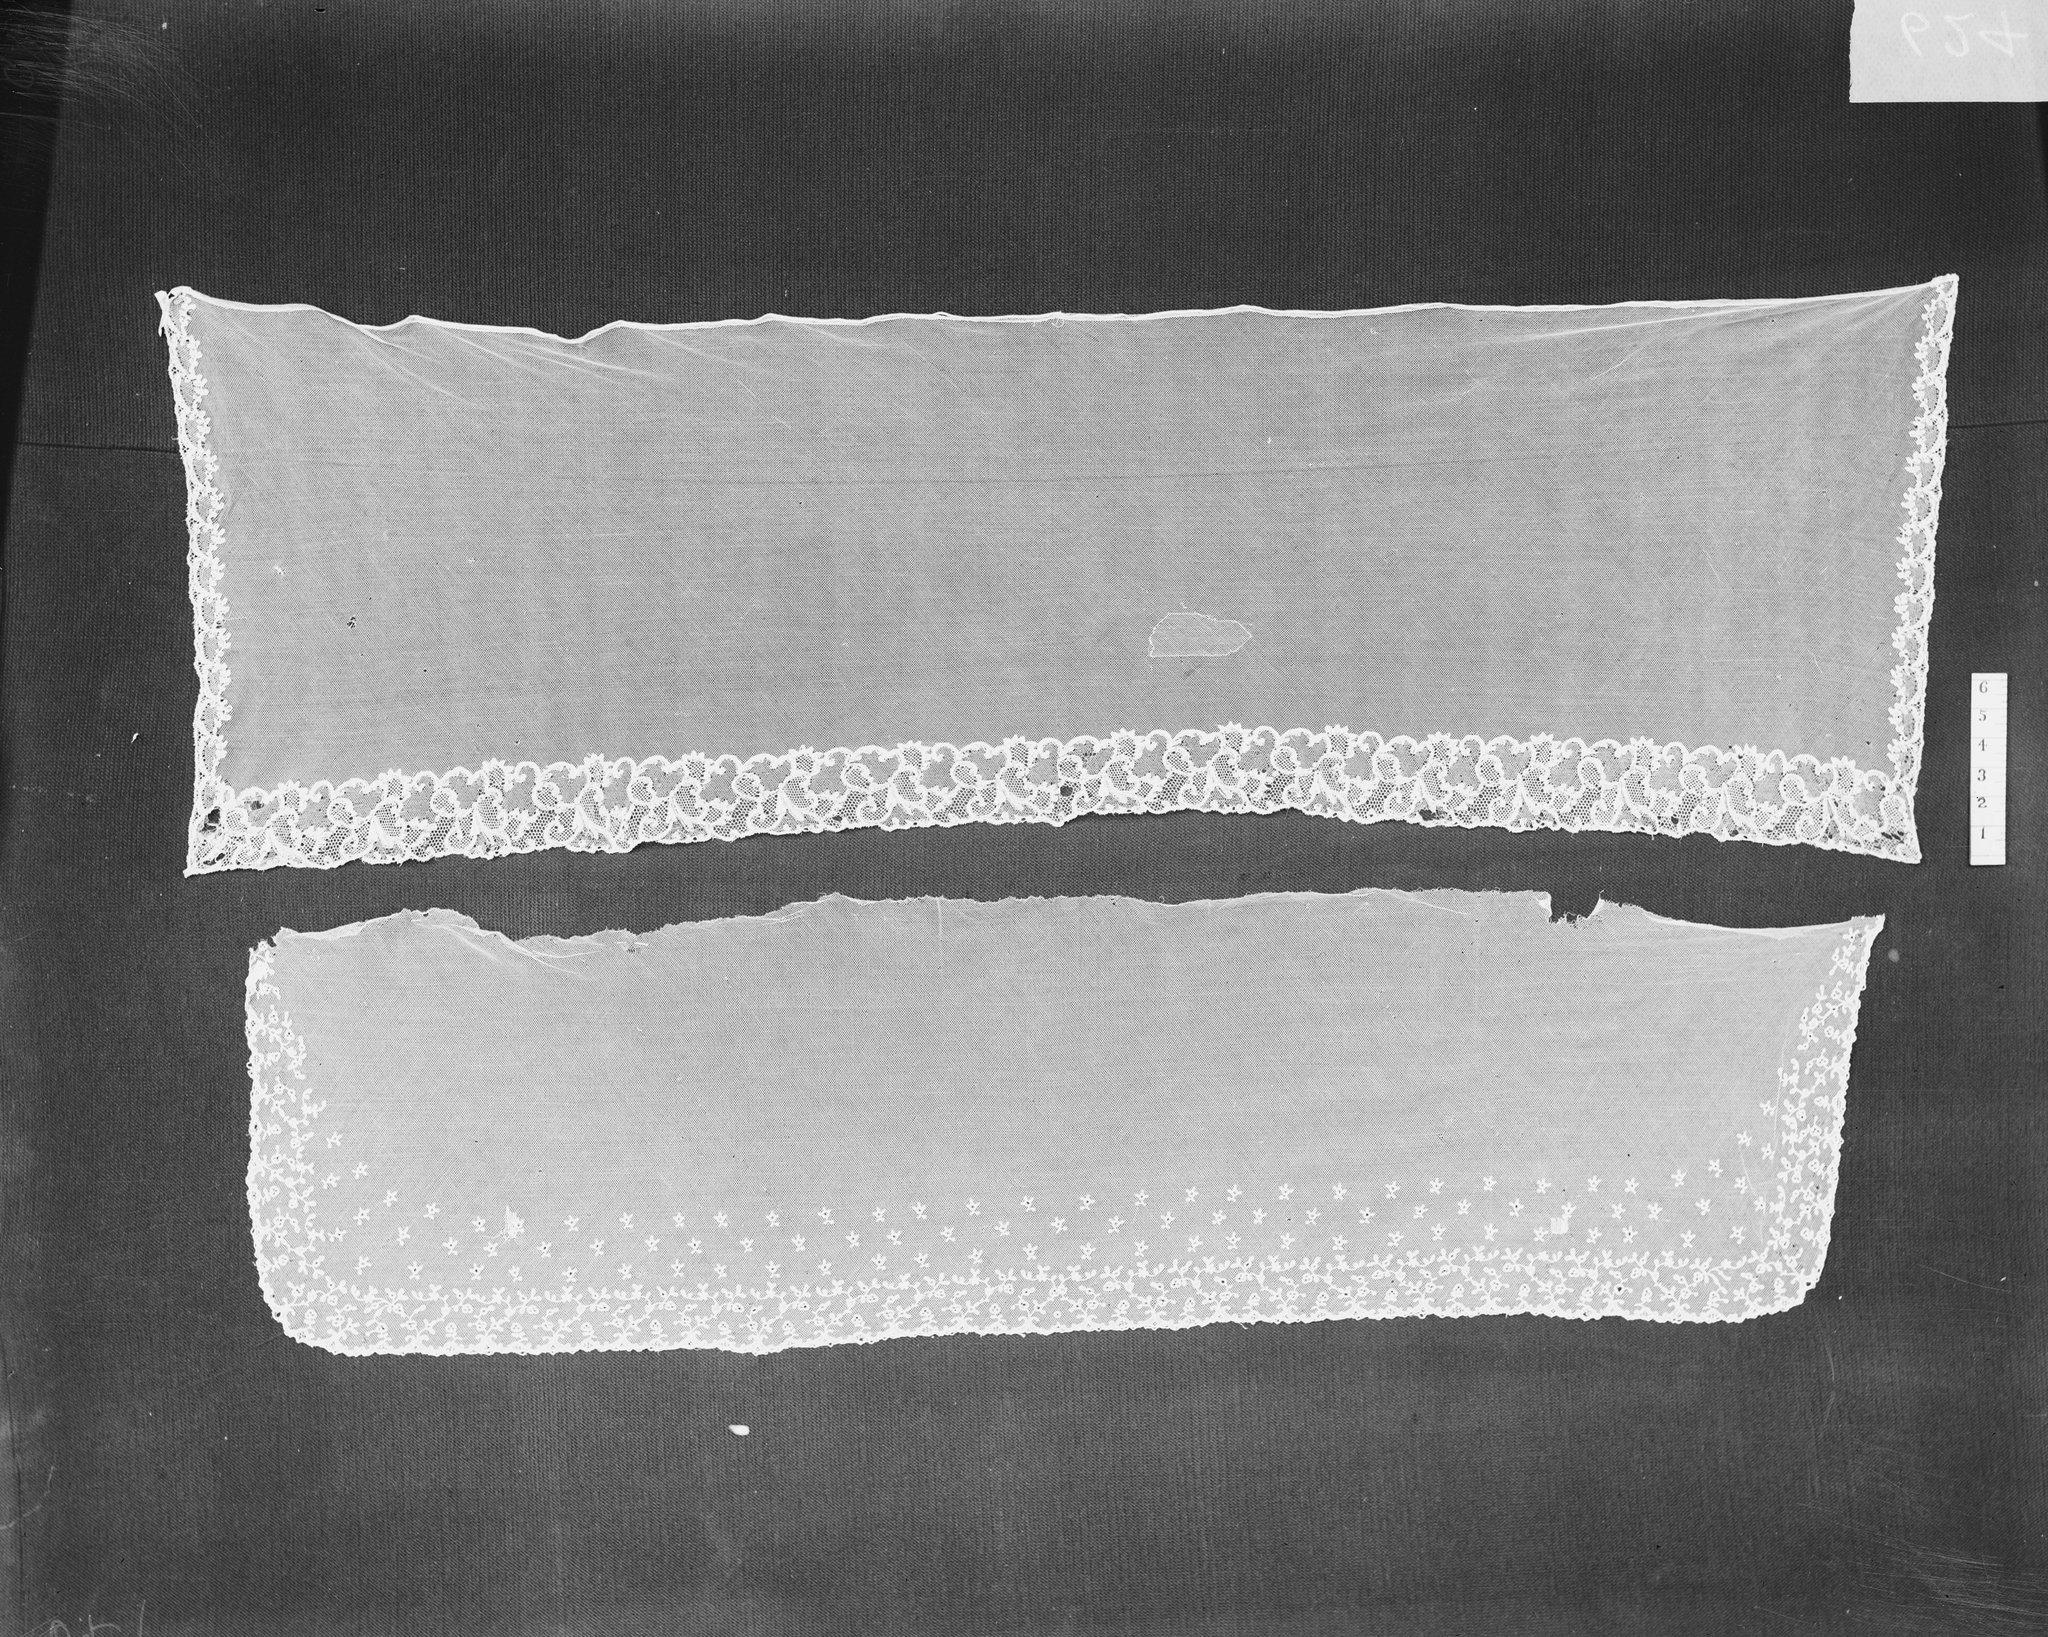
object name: veil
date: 1860